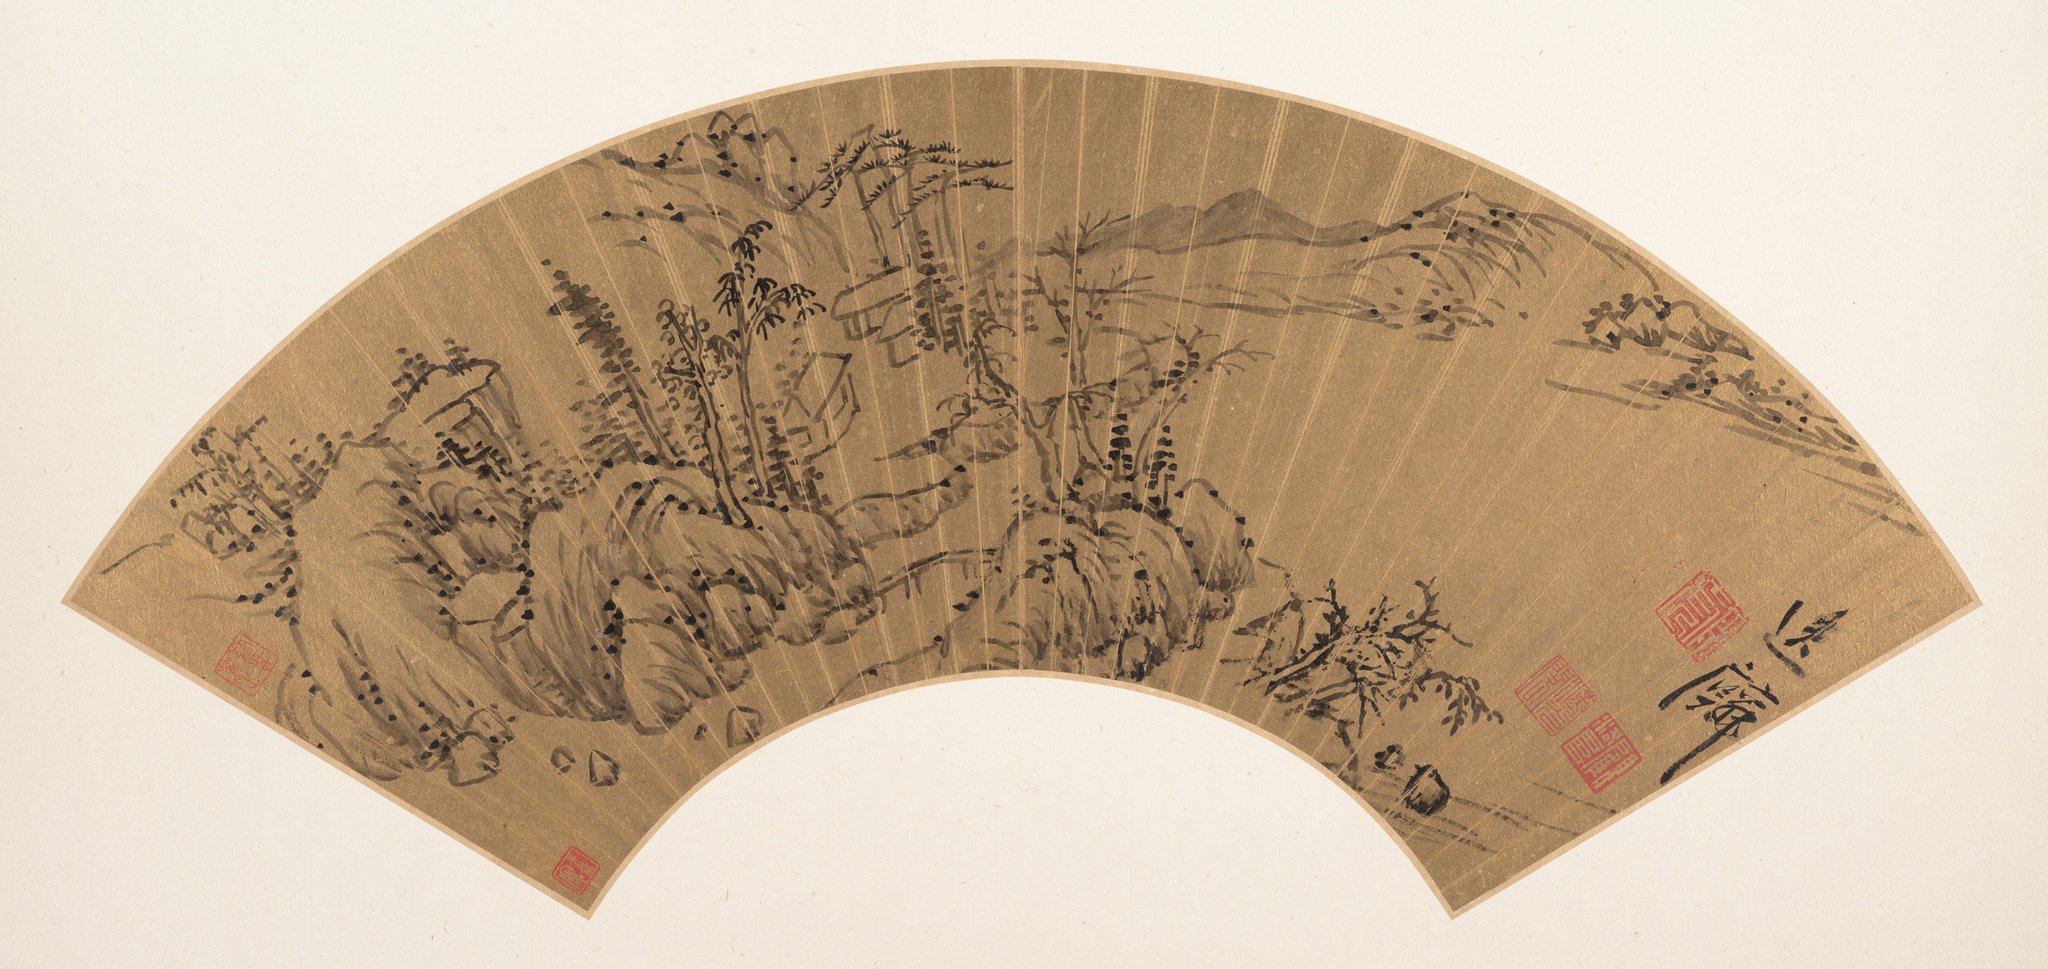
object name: folding fan mounted a an album leaf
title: Landscape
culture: chinese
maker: zou zhilin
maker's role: artist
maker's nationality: chinese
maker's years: 1574-1664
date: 1634-1666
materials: gold, ink, paper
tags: landscapes